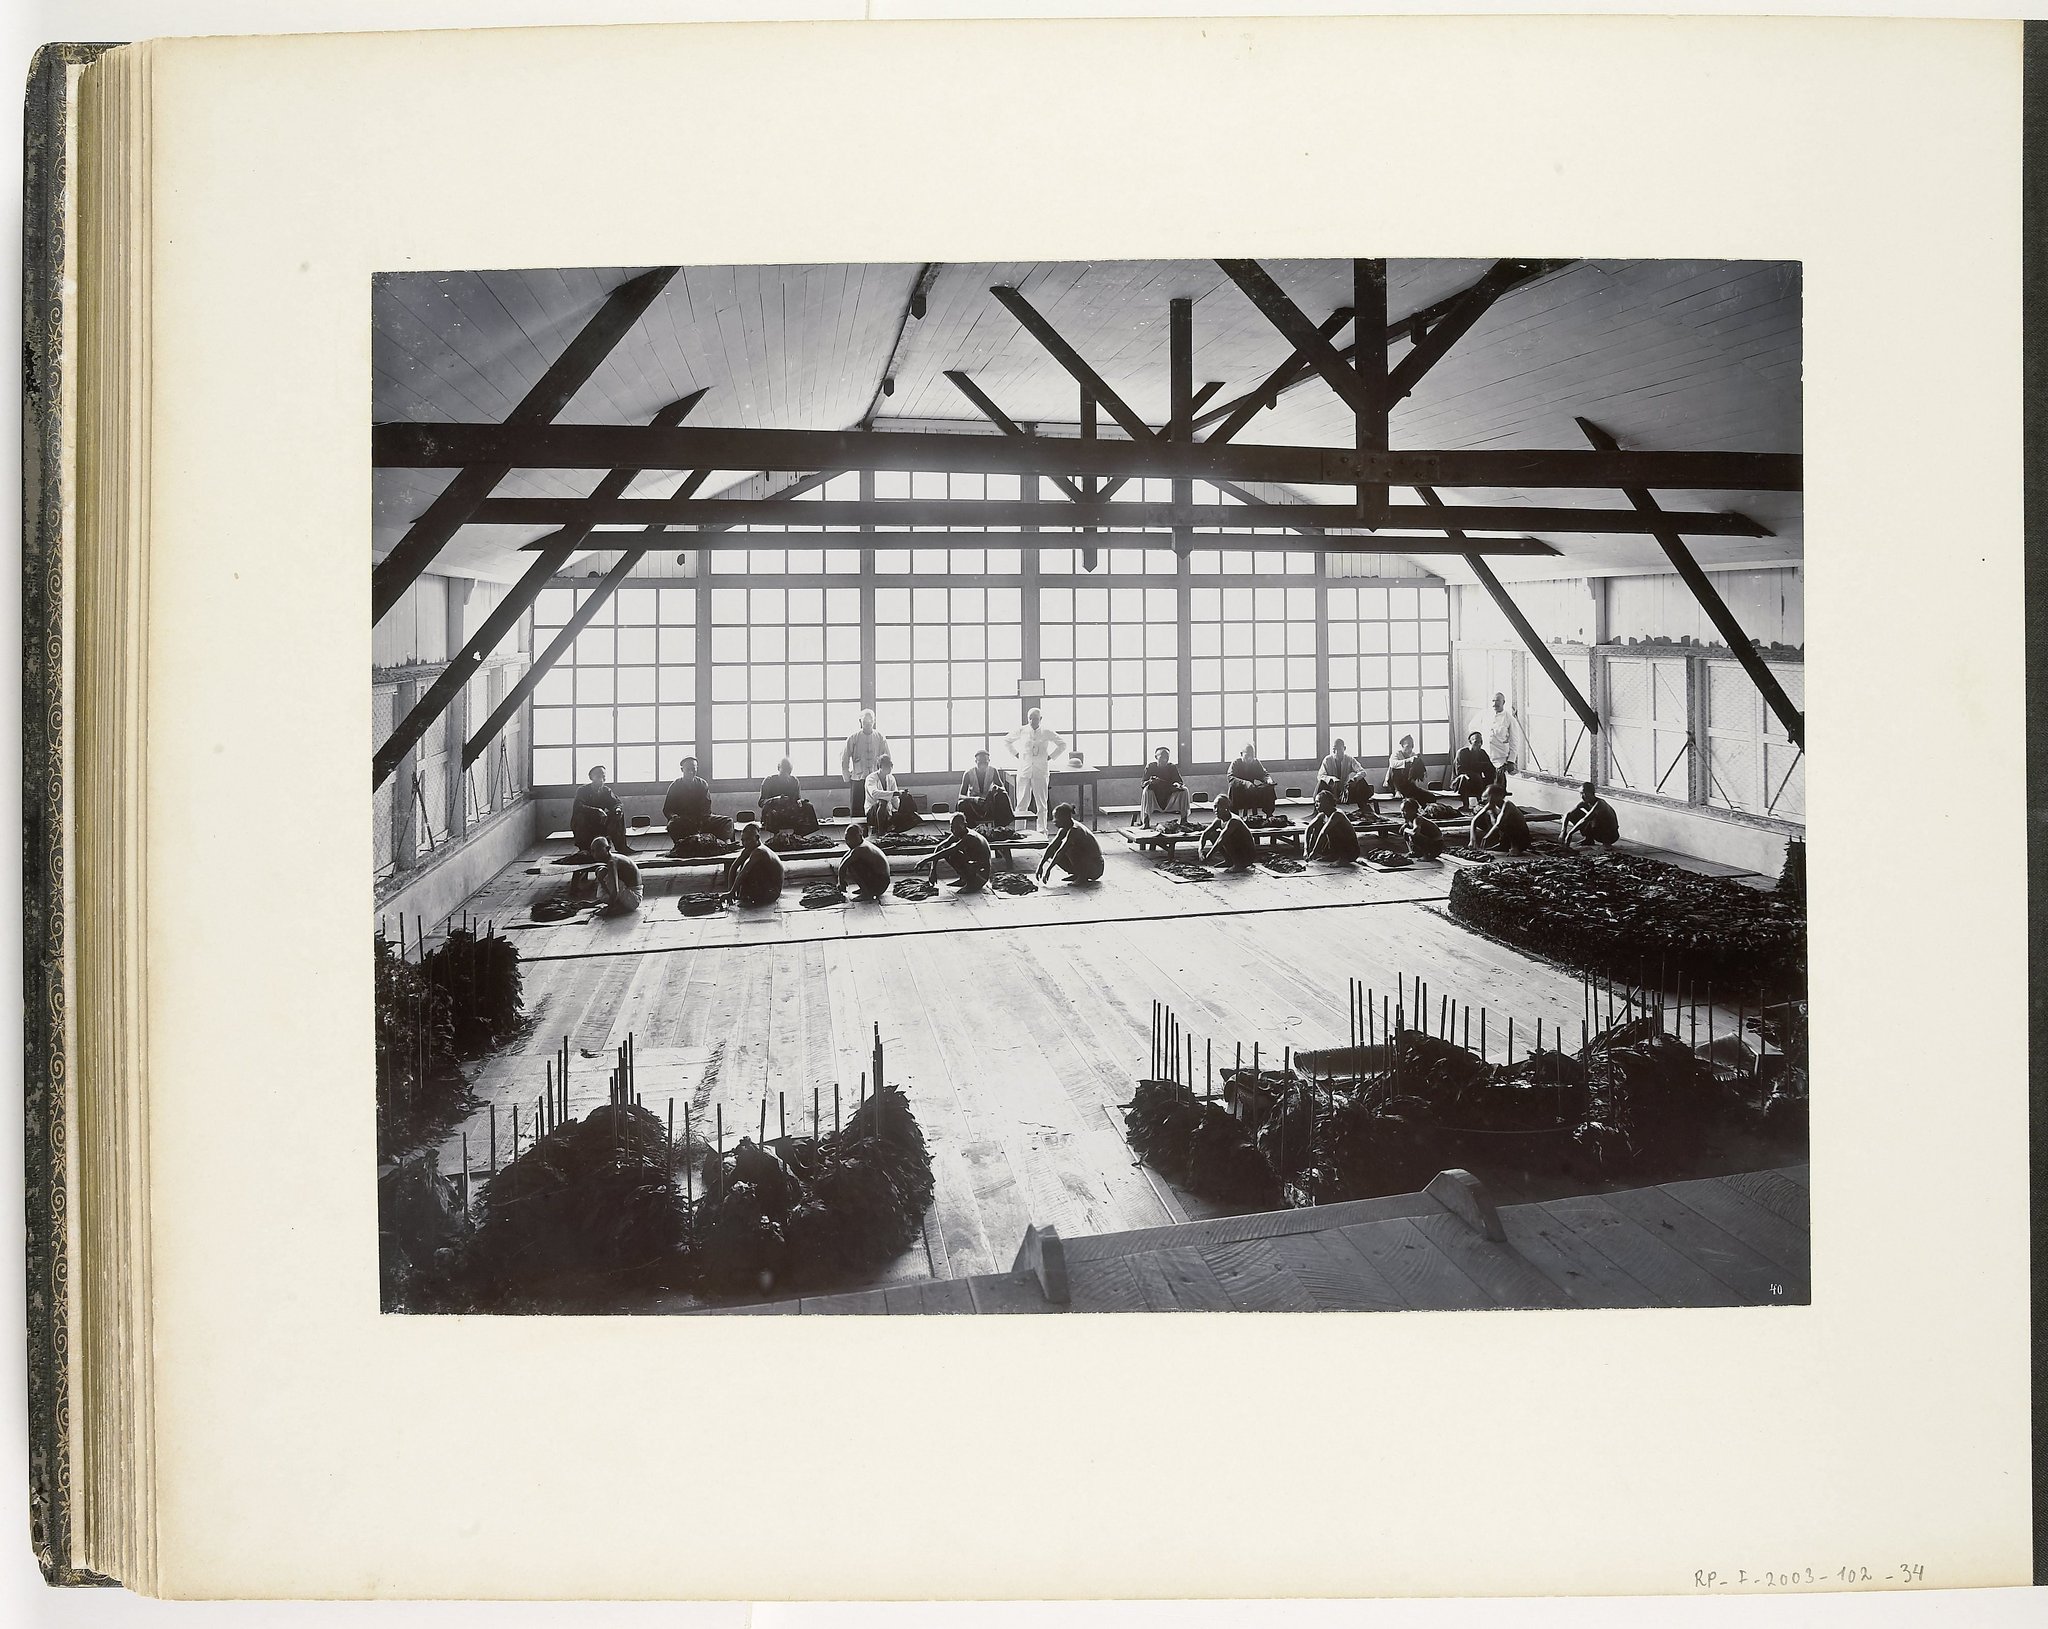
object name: photograph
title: Interieur van de fermenteerschuur Aneta Mineh, ontvangstruimte Helvetia, Sumatra (Fermentierscheune Interieur Empfangsraum Helvetia)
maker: carl j. kleingrothe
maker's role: fotograaf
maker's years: 1864-1925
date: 1885-1900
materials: photographic support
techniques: collodion silver print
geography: sumatra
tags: sumatra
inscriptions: number: ‘40’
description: Ontvangkamer in de fermenteerschuur Aneta Mineh van de tabaksonderneming Helvetia van de Deli Maatschappij op Sumatra. Onderdeel van het Sumatra fotoalbum van Paul en Lucie Sandel uit 1900.